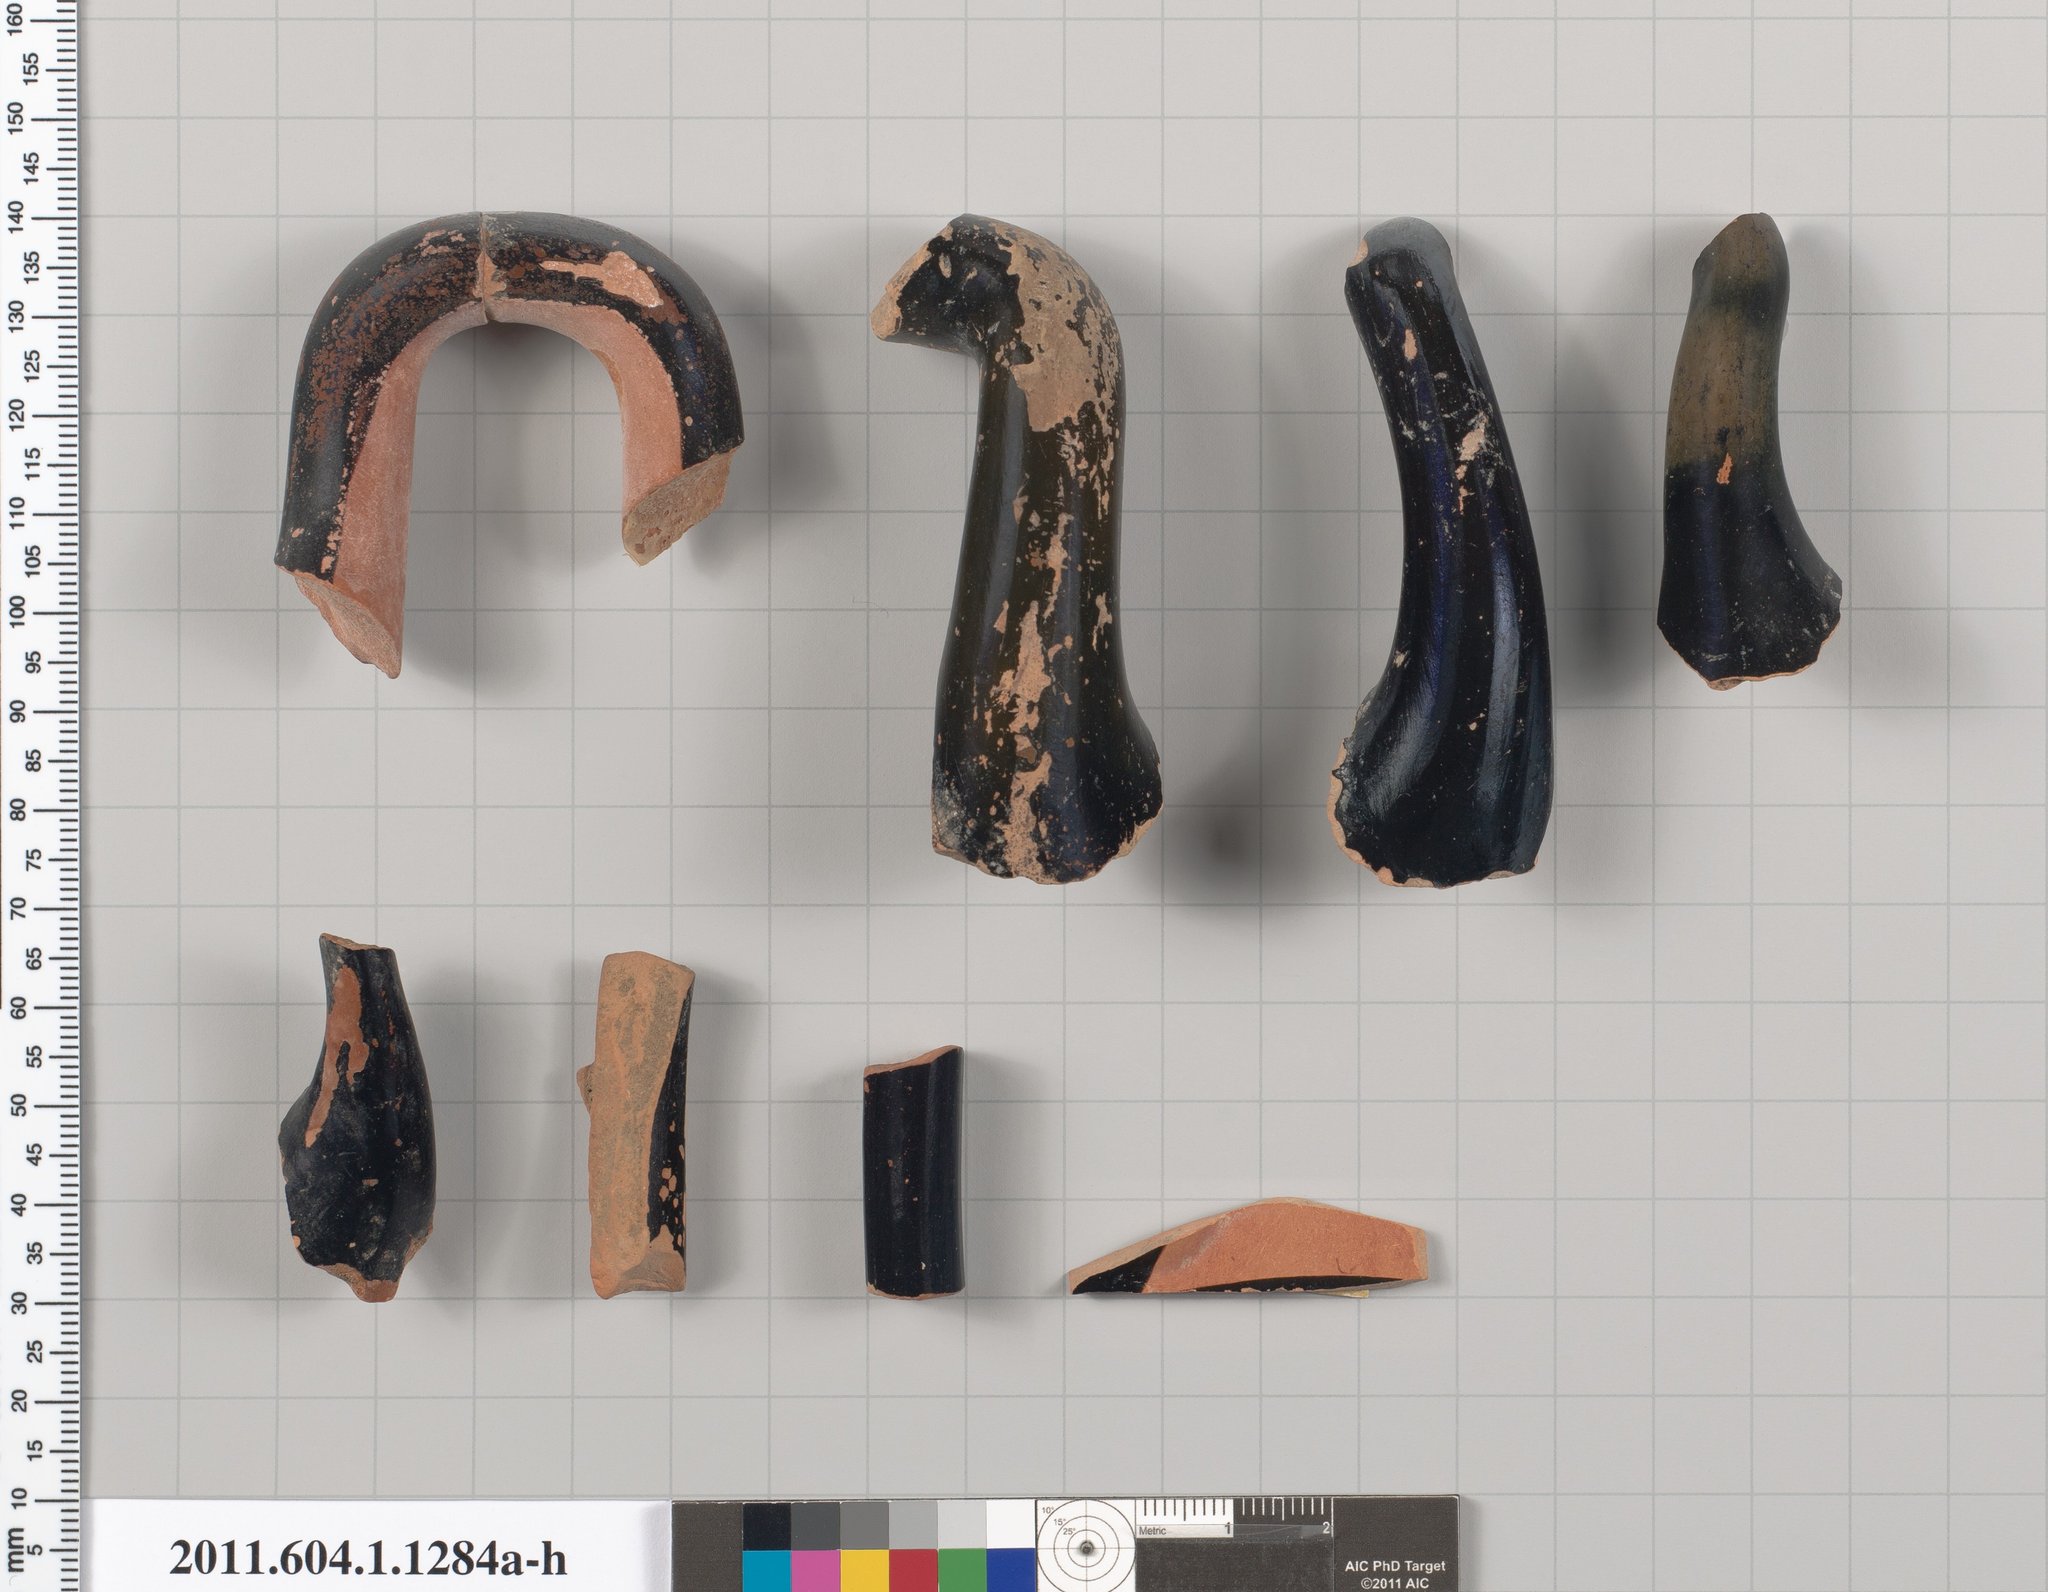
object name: kylix fragment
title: Terracotta fragments of kylikes (drinking cups)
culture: greek, attic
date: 500-401 BCE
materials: terracotta